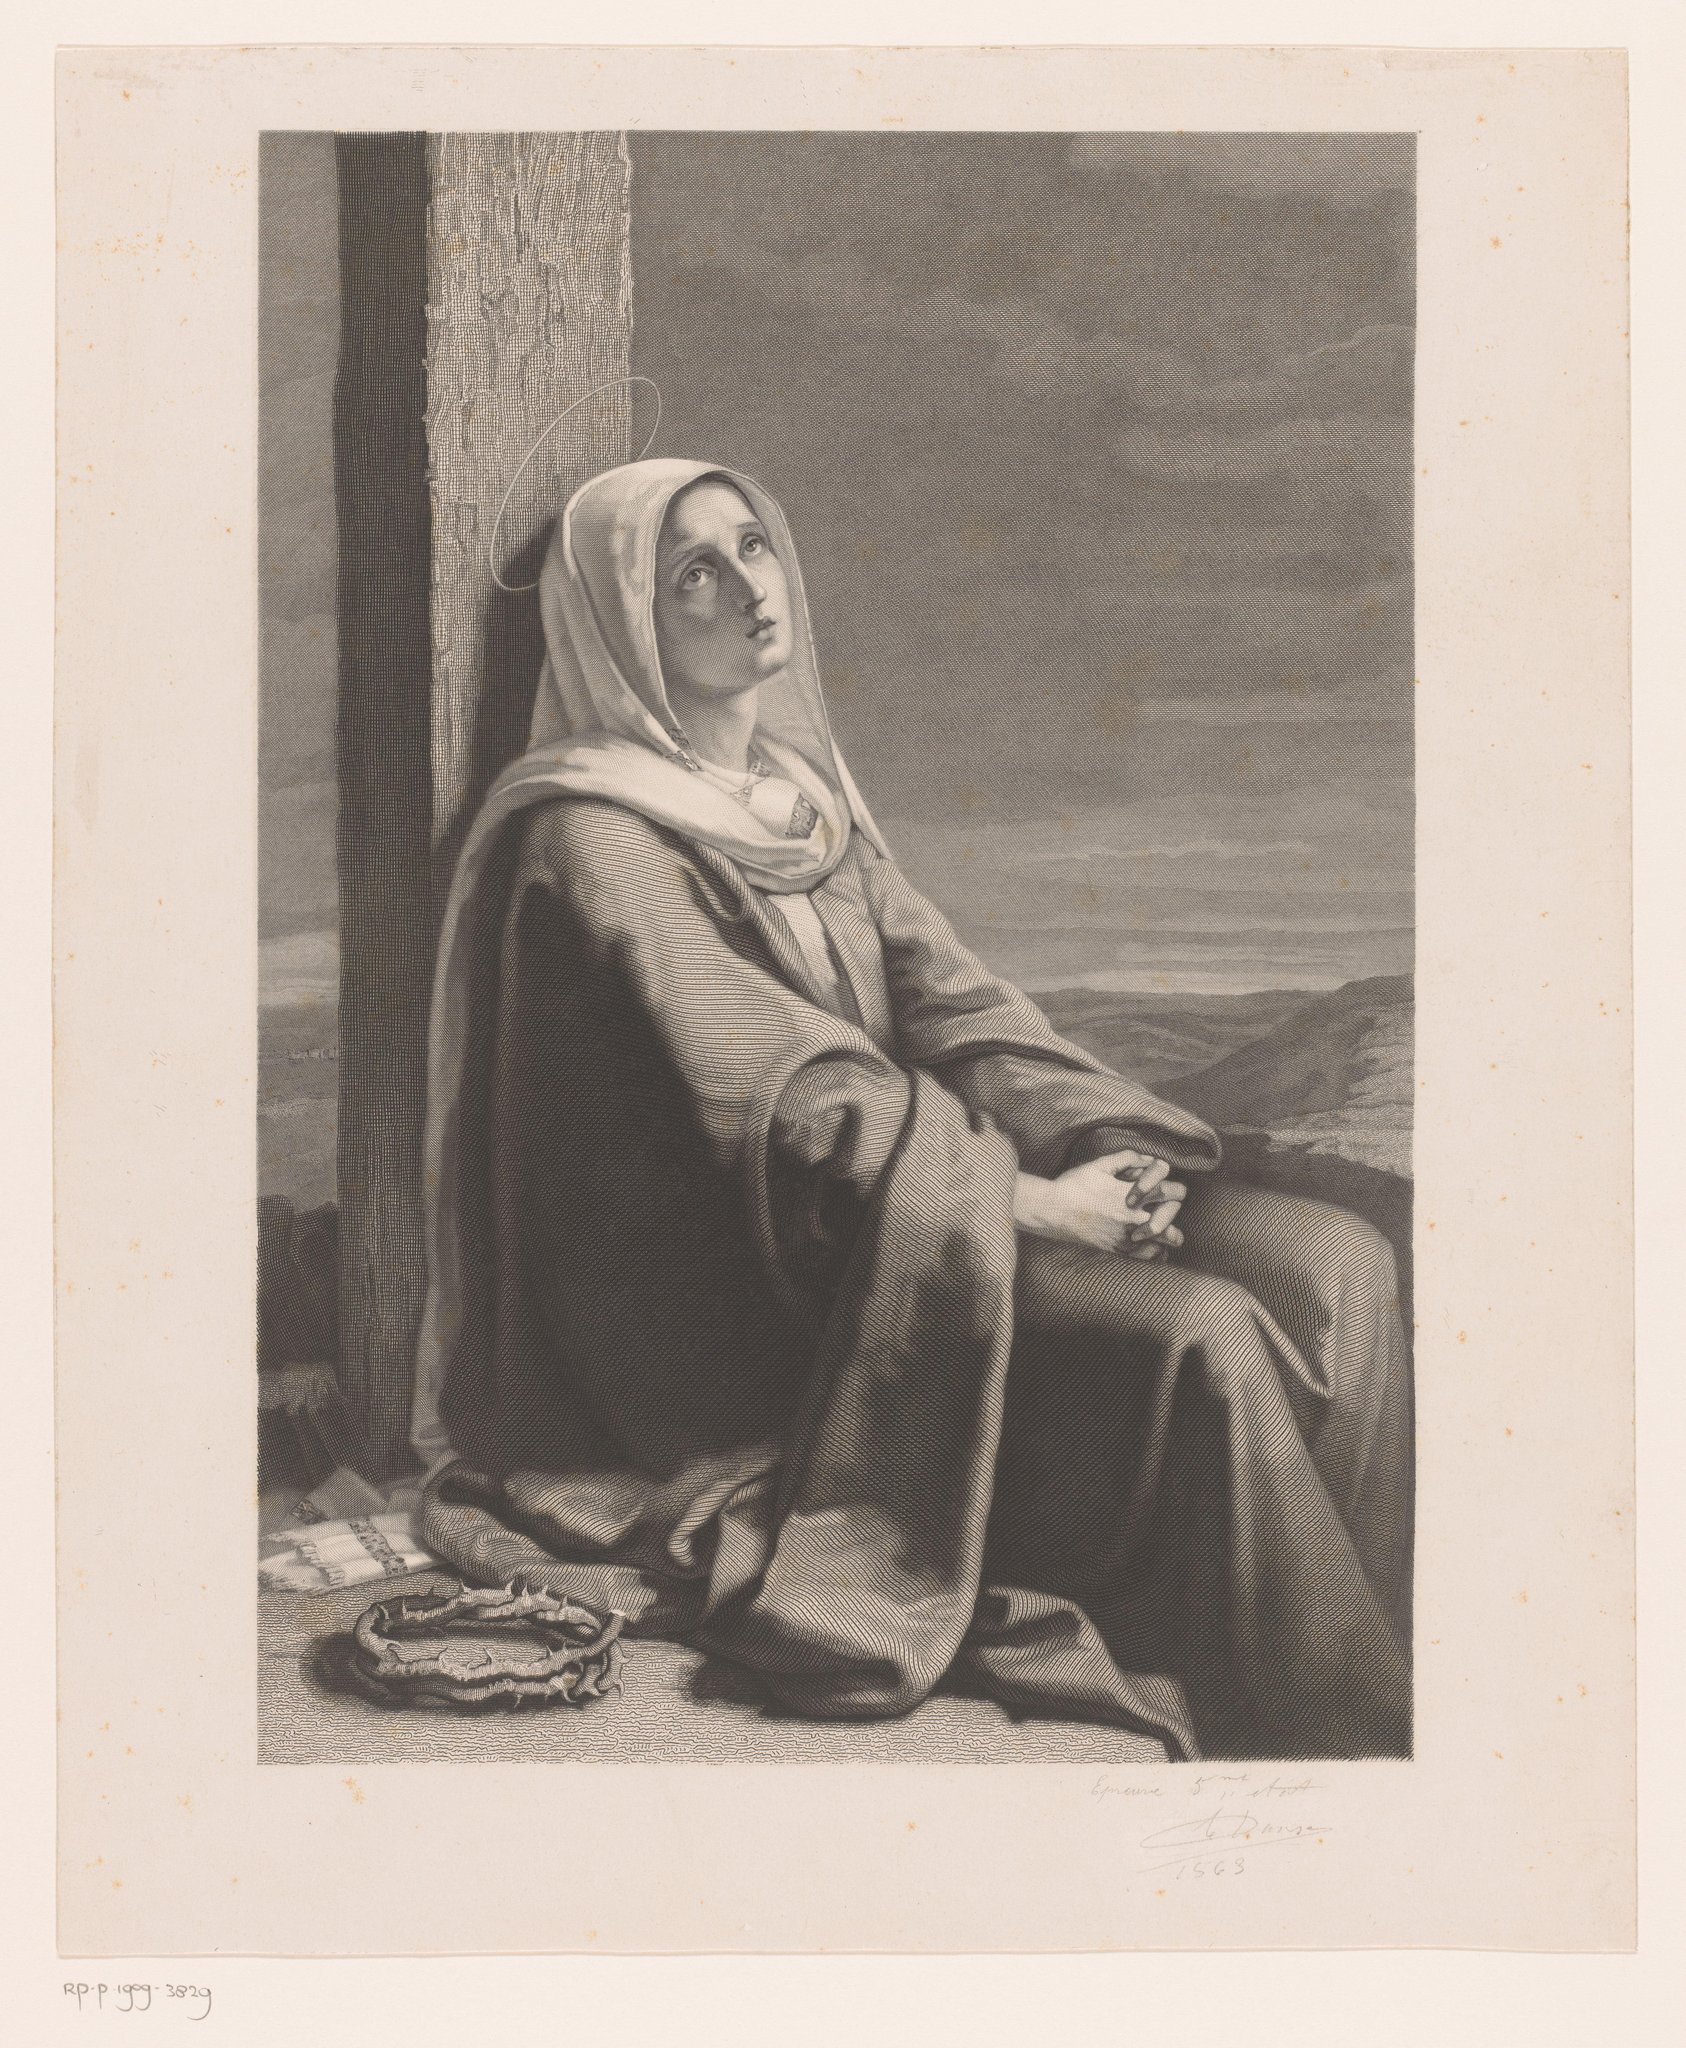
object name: print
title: Maria aan de voet van het kruis met naast haar de doornenkroon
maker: auguste danse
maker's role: print maker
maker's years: 1829-1929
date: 1863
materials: paper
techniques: engraving, etching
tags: mary with the instruments of the passion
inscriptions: annotation: ‘Epreuve 5me etat’, collector's mark: Lugt 2228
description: Hippert & Linnig onderscheiden vier staten van deze prent, waarvan de vierde definitief is, en met de letter. Niettemin draagt deze prent het opschrift 5me état (vijfde staat). Aangezien deze staat nog vóór de letter is, wordt geconcludeerd dat er tenminste zes staten van deze prent zijn.